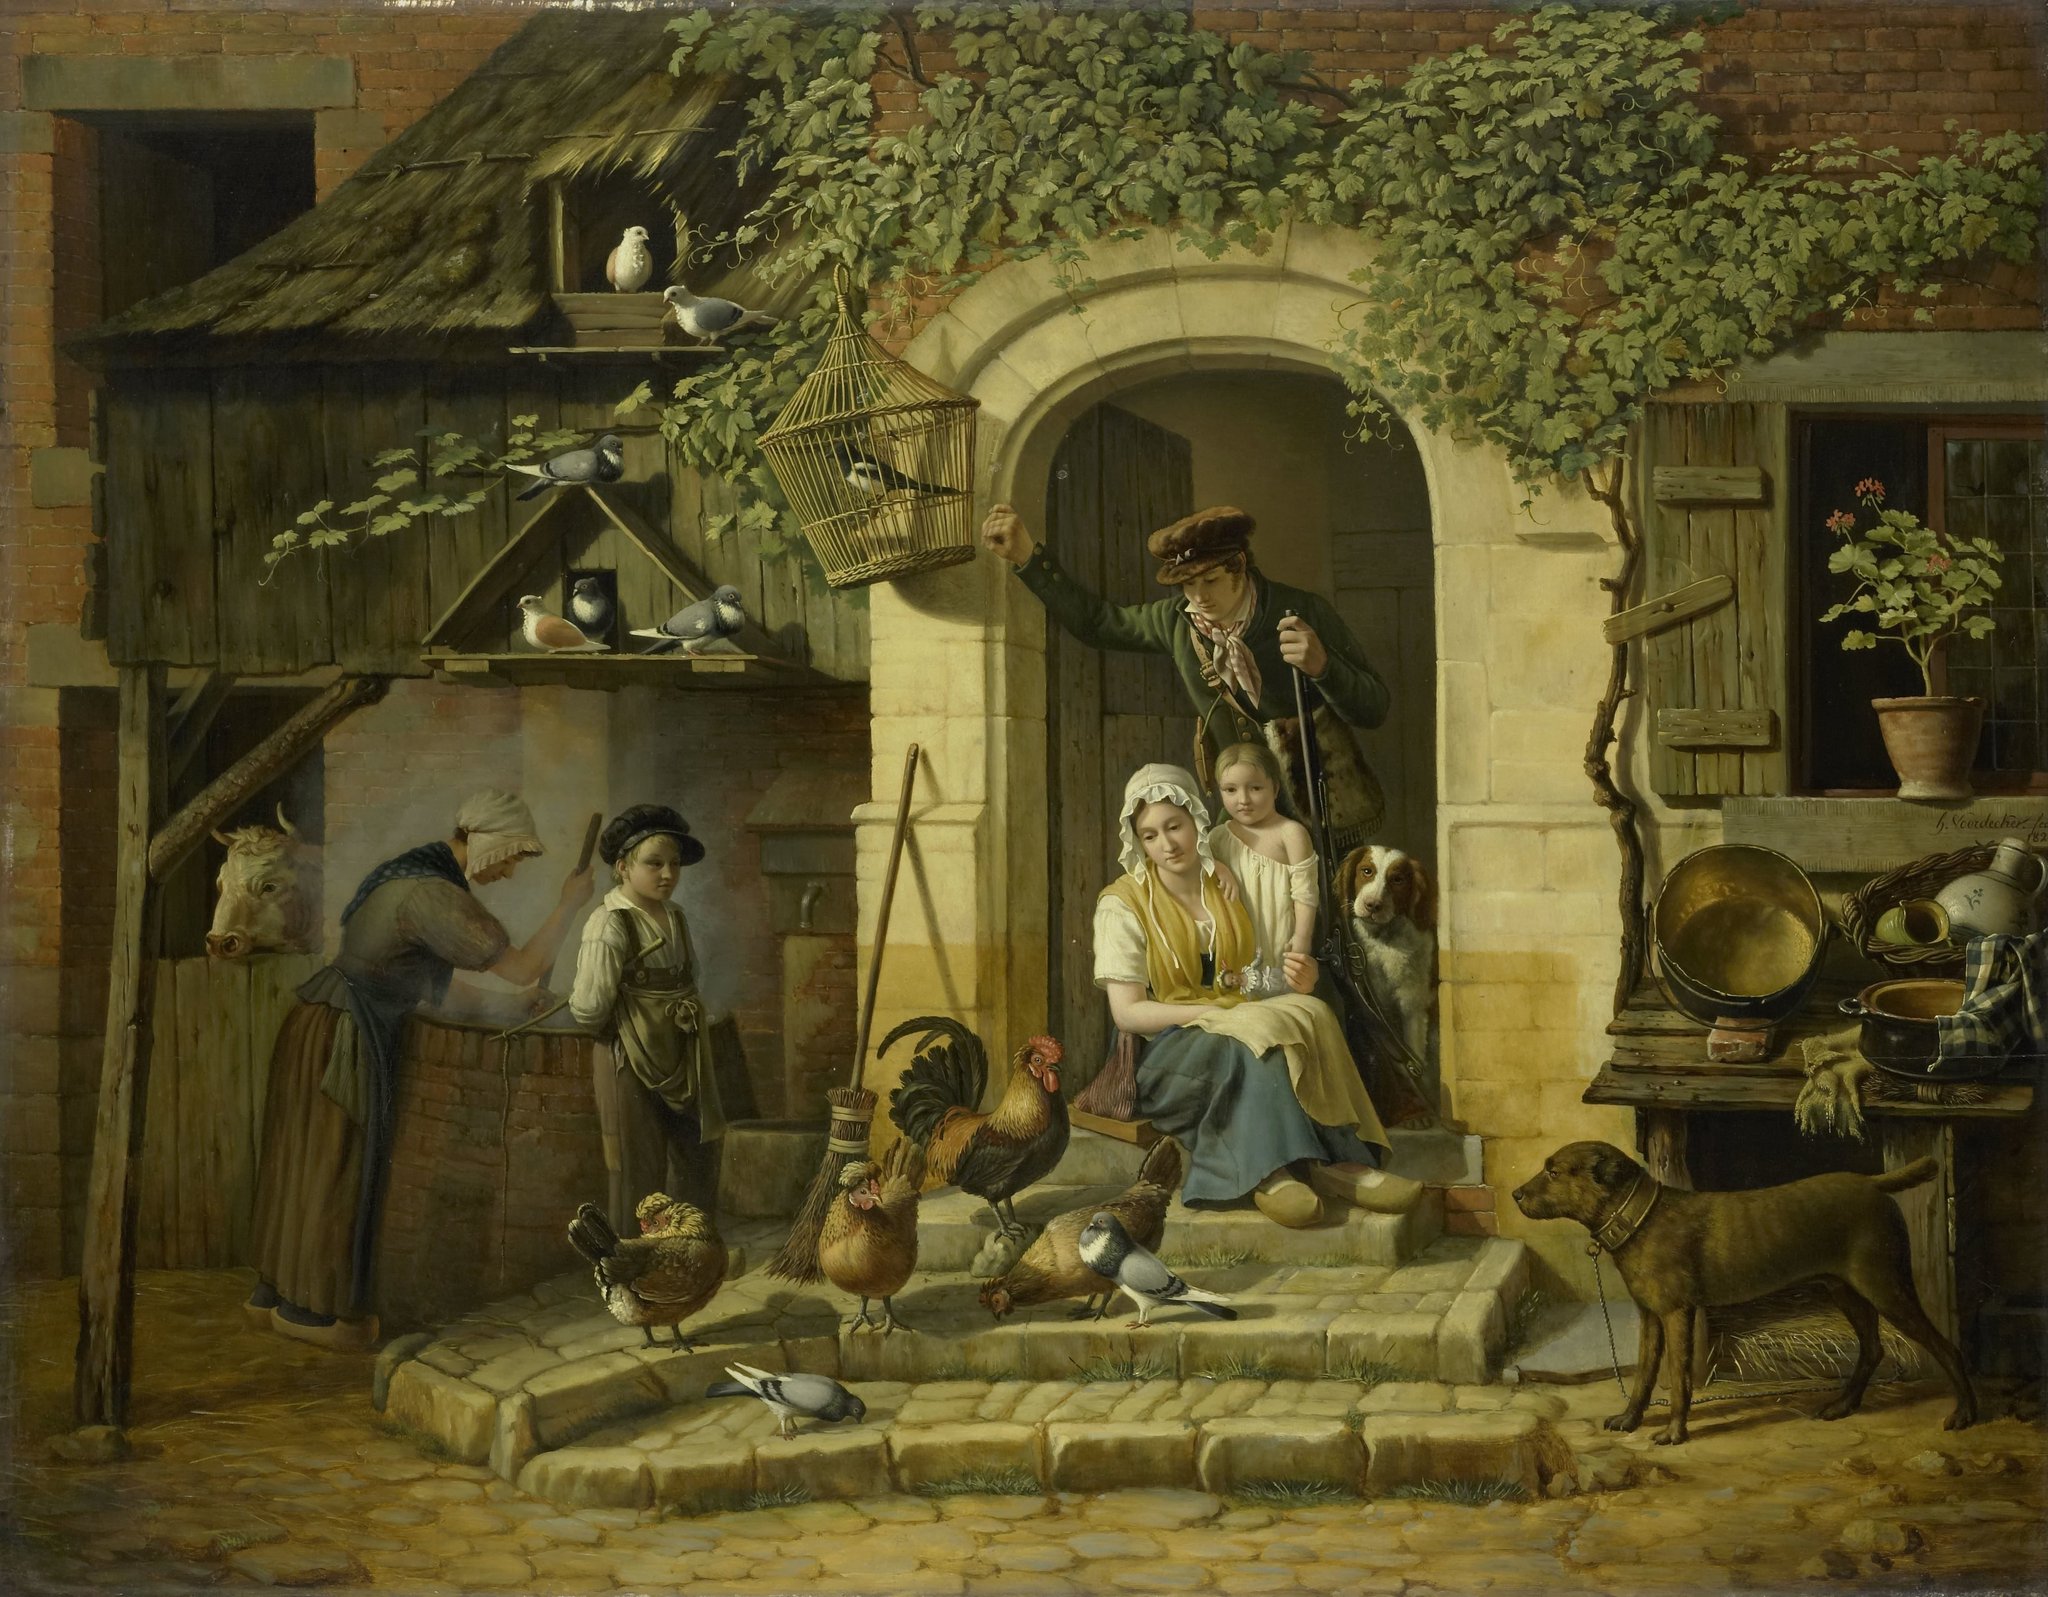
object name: painting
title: The Home of a Hunter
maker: henri voordecker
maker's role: painter, print maker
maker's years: 1779-1861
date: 1826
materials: oil, panel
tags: hunter, family life at home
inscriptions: signature and date: ‘H. Voordecker fecit 1826’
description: Jagerswoning. Een familie voor de deur van de woning. Moeder met kind zittend in de deuropening, achter haar een jonge man in jagerskleding. Op de trappen voor het huis lopen kippen en duiven, links van de deur nog meer duiven bij een duiventil. Links staat een meid bij een put, rechts een hond aan een ketting.